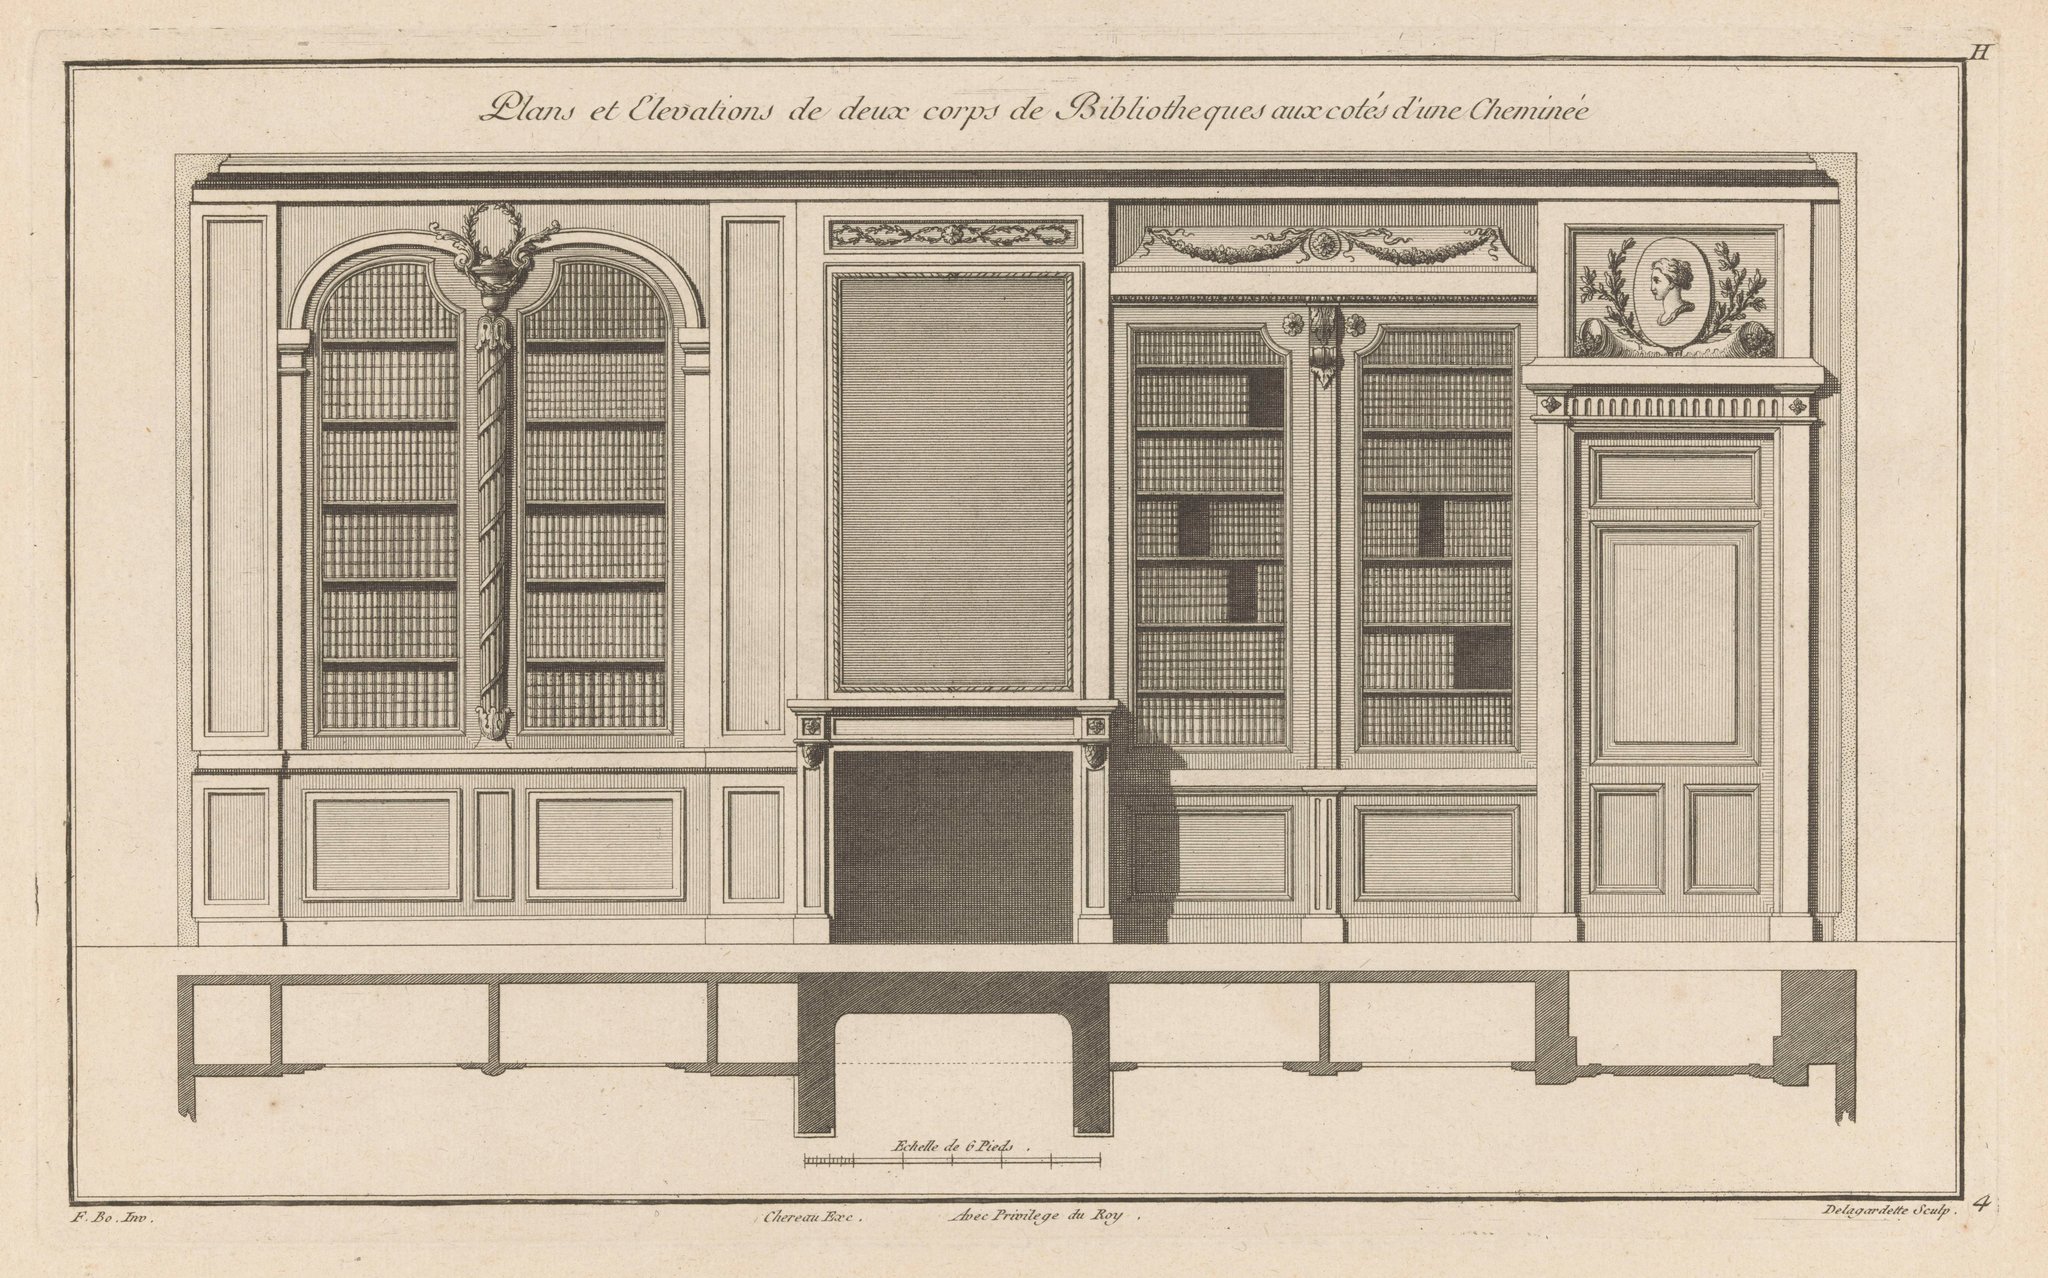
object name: ornament print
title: Schouw en boekenkasten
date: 1753-1782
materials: paper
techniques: engraving, etching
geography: paris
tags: bookshelves, ornament ~ medallion, open hearth, fire-place, door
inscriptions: collector's mark: Lugt 2760, collector's mark: Lugt 2228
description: Ontwerp en plattegrond van twee boekenkasten aan weerszijden van een schouw. Rechts een deur met dessus-de-porte met een vrouwenportret en profil in een ovaal medaillon.